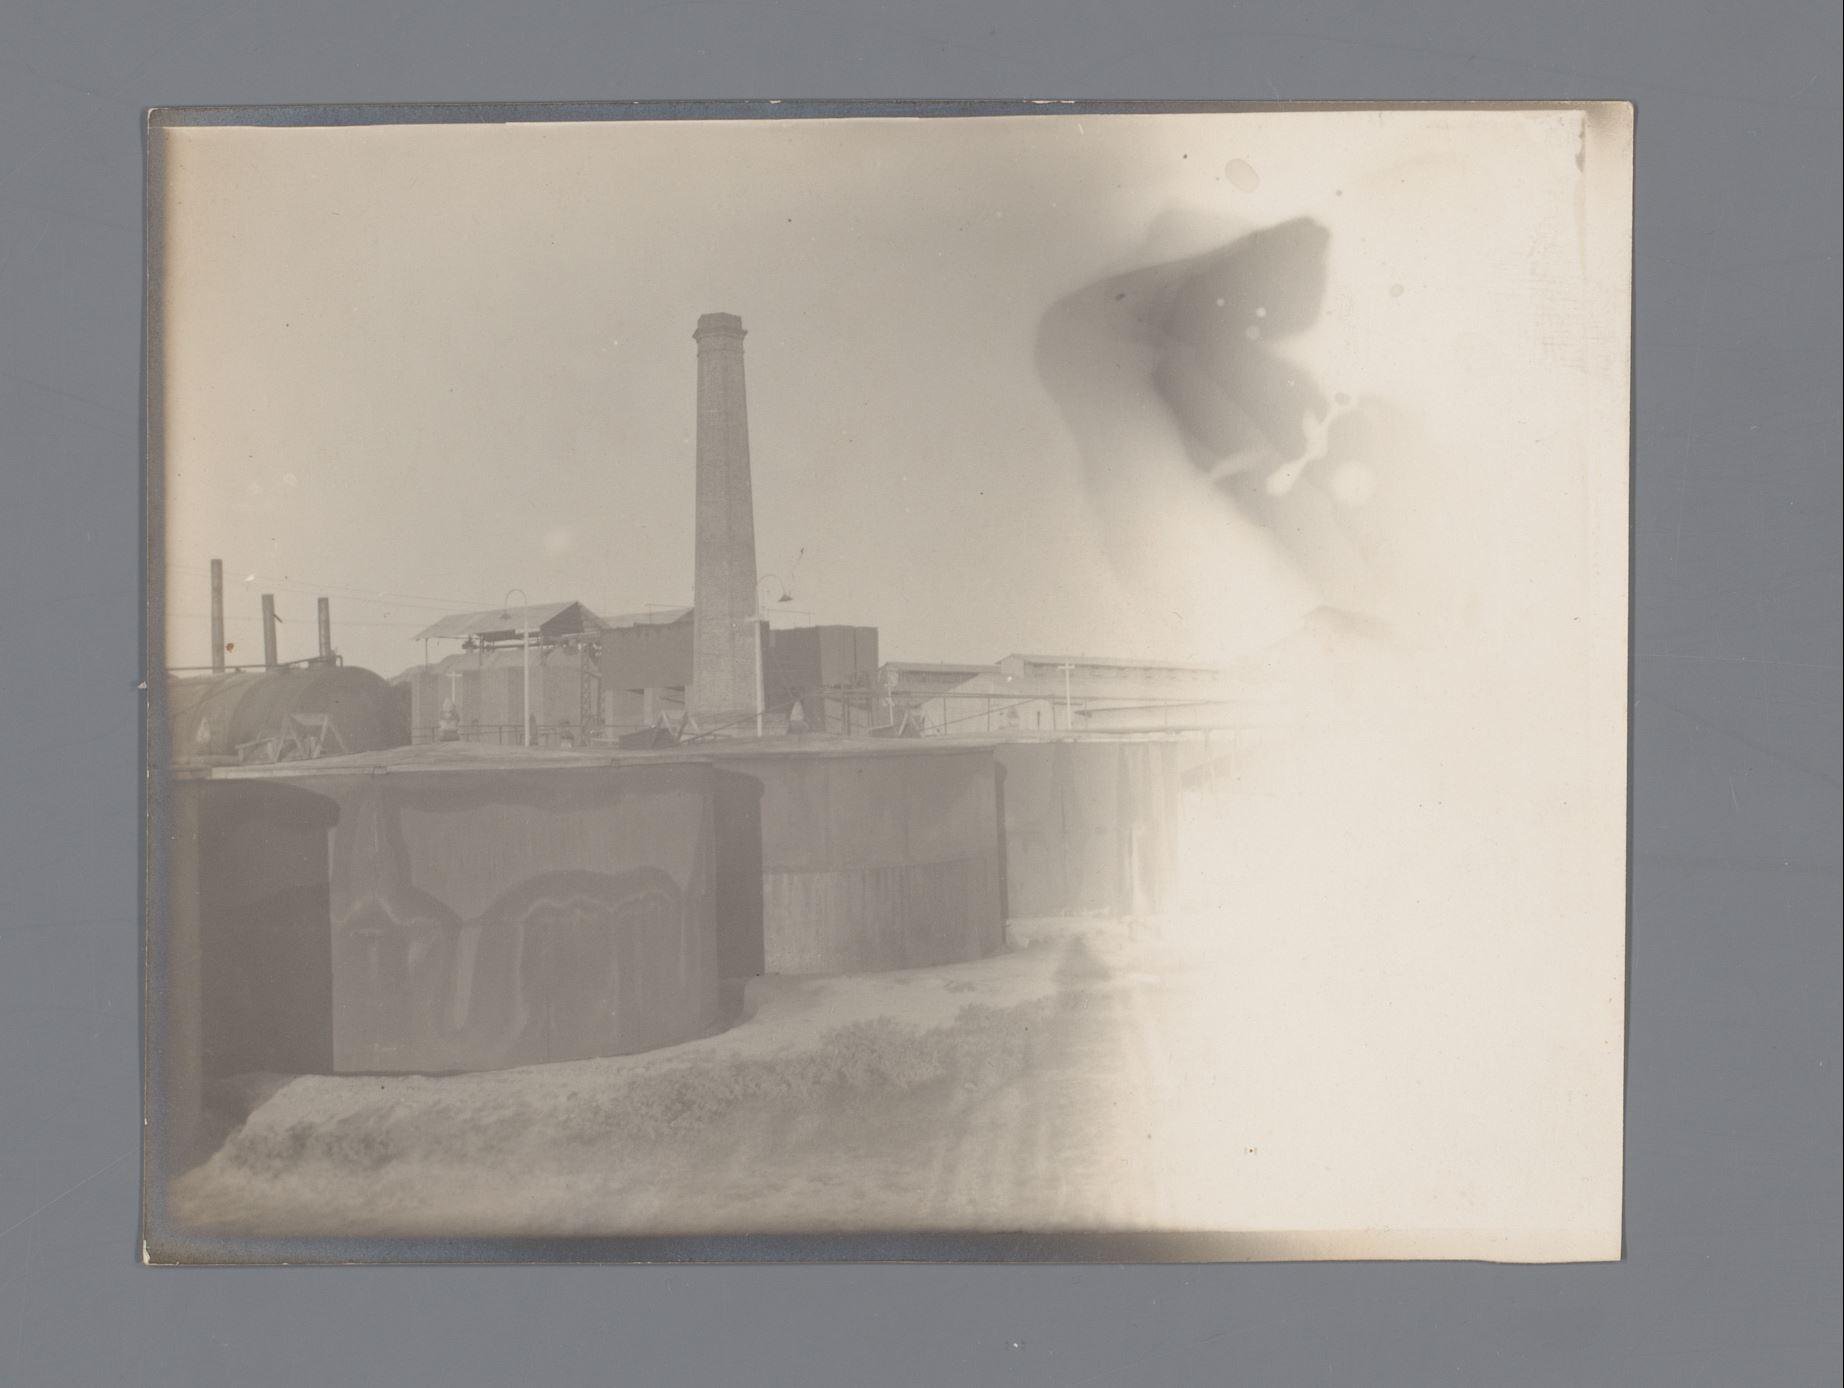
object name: photograph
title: Gezicht op een fabriek, Zuid-Oost Azië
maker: jan adriani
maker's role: fotograaf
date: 1907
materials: photographic support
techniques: gelatin silver print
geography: southeast asia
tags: factory-building